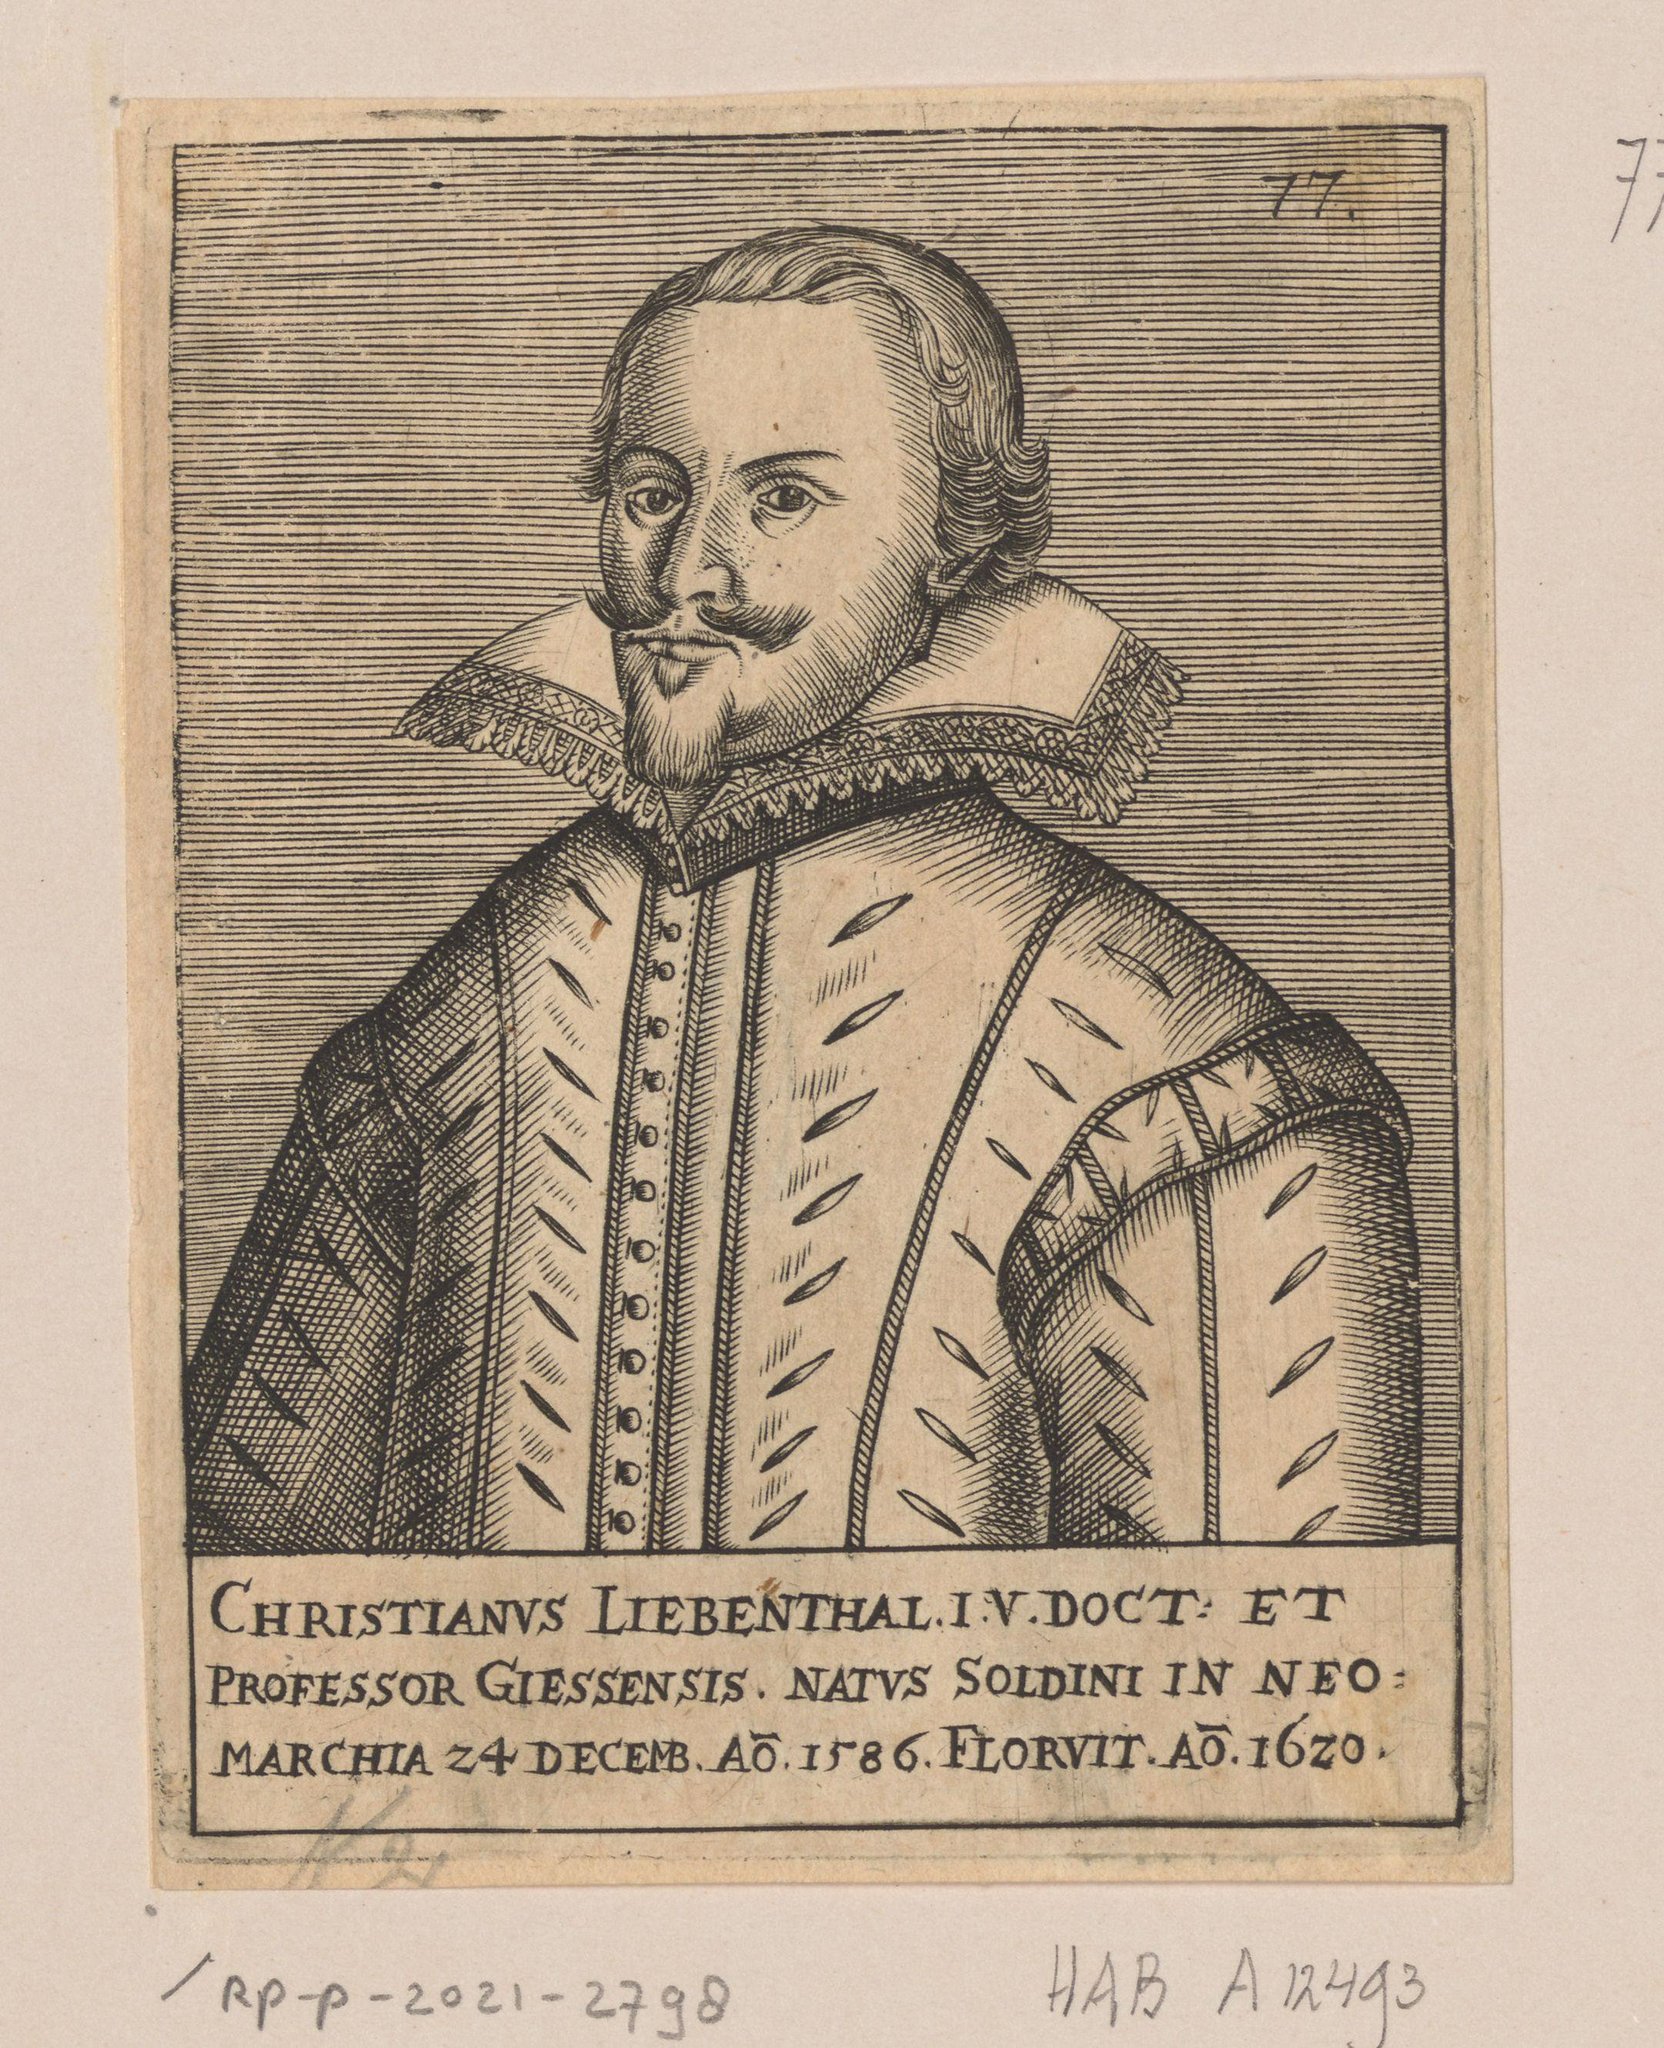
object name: print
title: Portret van Christan Liebenthal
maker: Anonymous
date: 1751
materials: paper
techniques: engraving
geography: germany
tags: historical persons, scholar, philosopher (+ portrait of scholar, scientist)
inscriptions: collector's mark: Lugt 2228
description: Prent waarschijnlijk uit: Küster, Georg Gottfried. Martin Friedrich Seidels Bilder-Sammlung in welcher hundert, gröstentheils in der Mark Brandenburg (…). Berlijn: Buchladen bey der Real-Schule, 1751.